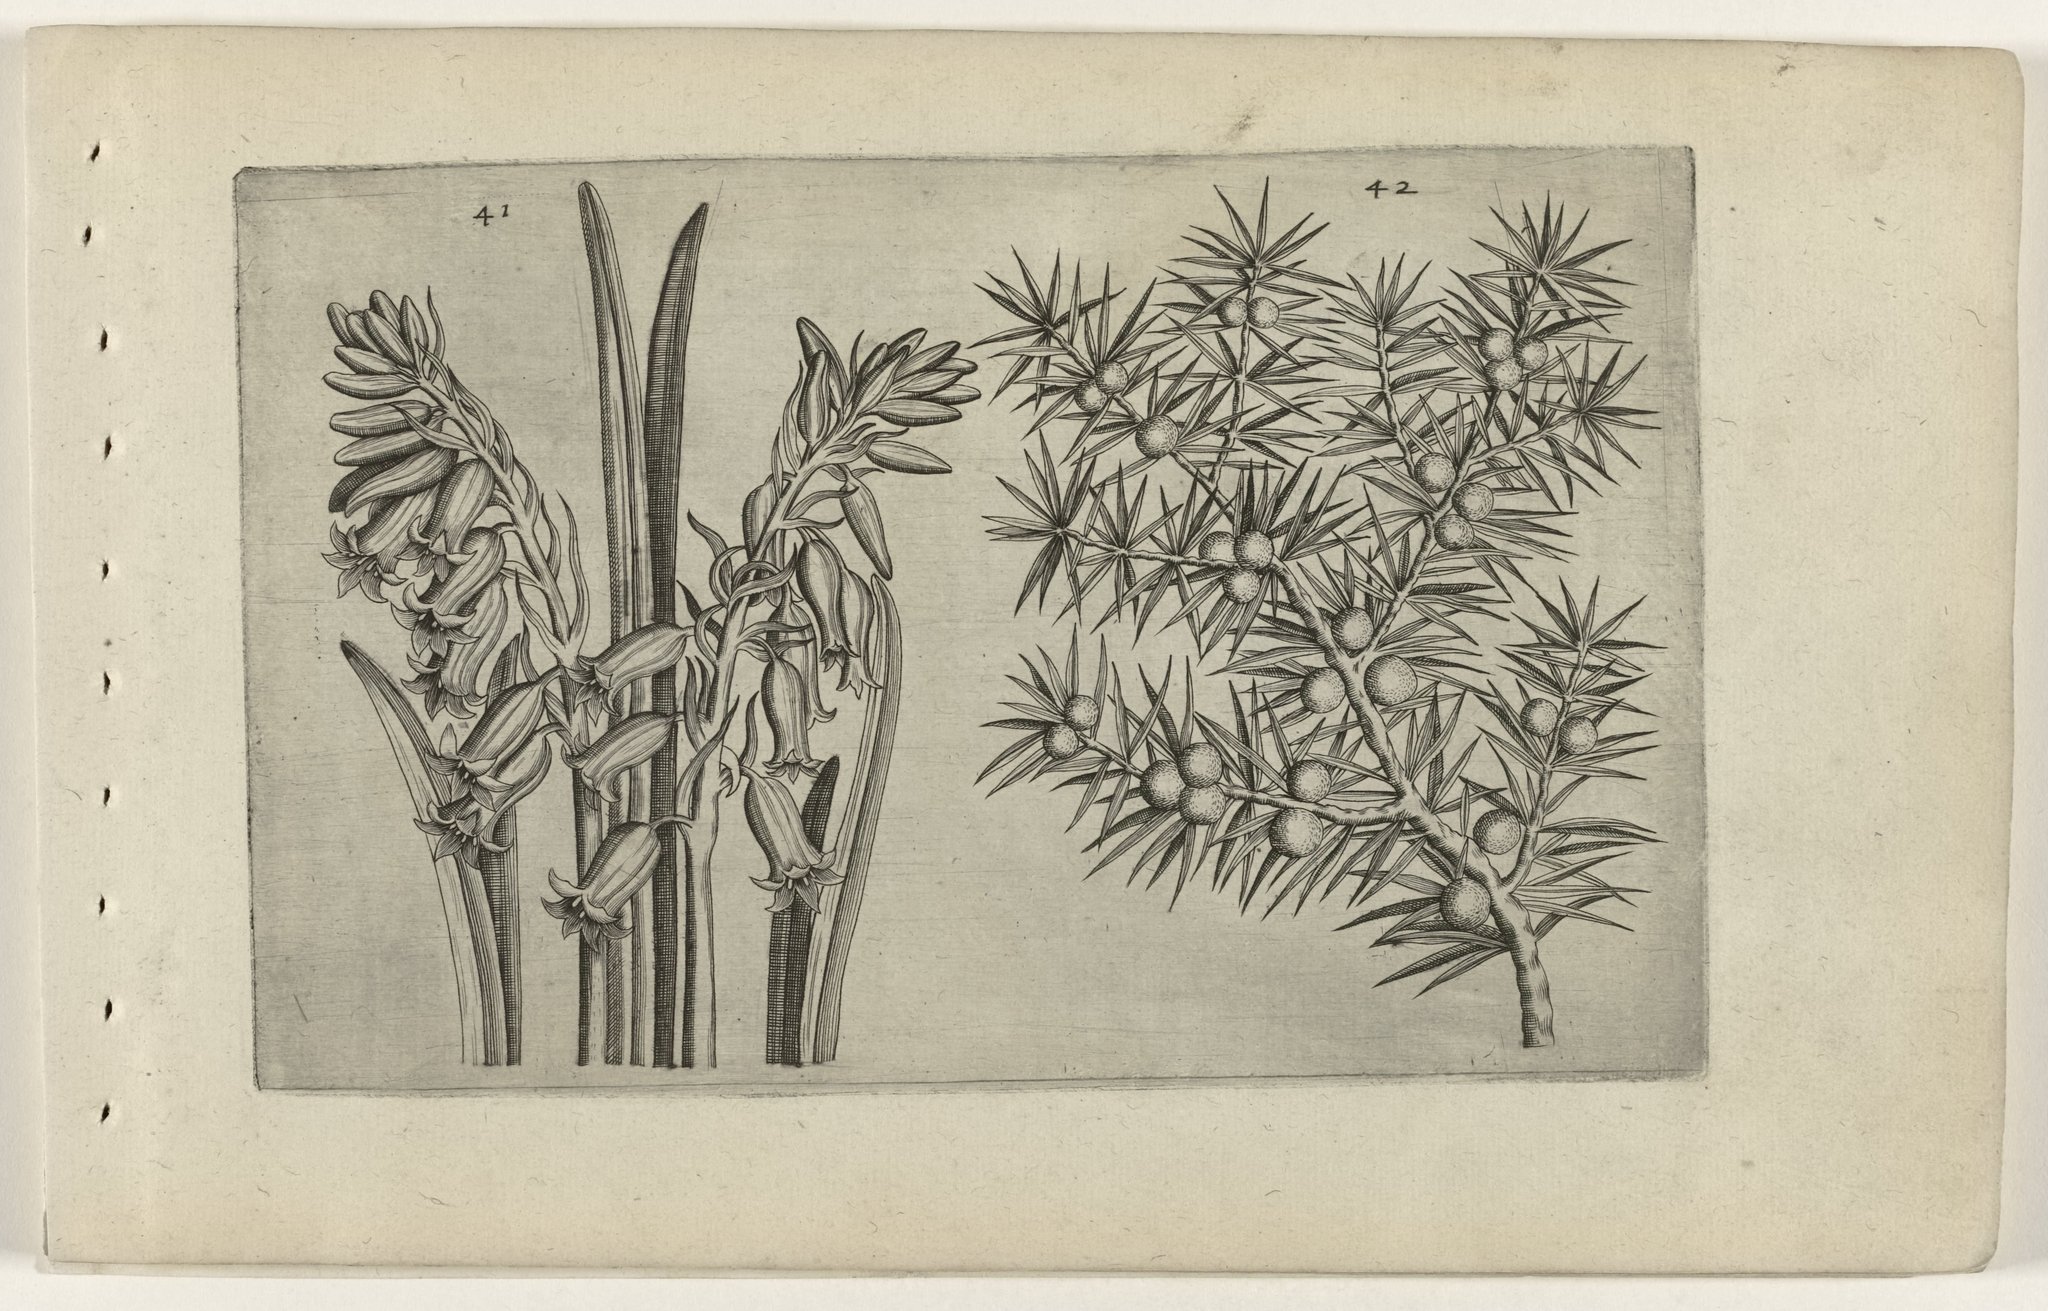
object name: album leaf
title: Hyacint en jeneverbes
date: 1600-1604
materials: paper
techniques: engraving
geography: cologne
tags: shrubs: juniper, botany, flowers: hyacinth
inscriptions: collector's mark: Lugt 2228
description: De prenten RP-P-2012-24-1 t/m 61 waren oorspronkelijk als serie samengebonden. De naaigaten op de bladen zijn nog zichtbaar. Het betreft de reeks getiteld: Cognoscite lilia, bestaande uit een titelprent en 60 gravures met 119 genummerde weergaven van planten, bloemen en vruchten, versierd met rinceaux en kleine voorstellingen van dieren. Het gaat om proefdrukken van deze reeks gravures, voor de opschriften en, deels, voor de nummering. Op enkele prenten zijn de nummers met de hand aangebracht. Op de titelprent ontbreekt nog het adres van Crispijn de Passe en Hans Woutneel. De titel is hoogstwaarschijnlijk gegraveerd door Matthias Quad. Deze werkte voor De Passe in Keulen tot 1604. De reeks moet in dit jaar of daarvoor tot stand zijn gebracht. In ieder geval voor 1608, aangezien de uitgever Hans Woutneel in of voor dat jaar overleed. In ieder geval voor 1608, aangezien de uitgever Hans Woutneel in of voor dat jaar overleed. De gravures worden door Ilja Veldman en Anthony Griffiths beschouwd als eigenhandig werk van Crispijn de Passe I. Een van de prenten uit de reeks ontbreekt (nr 21-22) en is vervangen door een ingekleurde afdruk uit een latere uitgave (RP-P-2012-24-61), die onder de titel Altera Pars is opgenomen in de Hortus Floridus, uitgegeven door Crispijn de Passe I en die verder bestaat uit platen van Crispijn de Passe II. De prenten afkomstig uit deze uitgave zijn op de verso voorzien van tekst in boekdruk. De vervangende prent maakte geen deel uit van de gebonden serie aangezien dit blad als enige geen naaigaten heeft. Een deel van de planten, bloemen en vruchten in de Cognoscite lilia gaat terug of is gebaseerd op een reeks aquarellen van Jacques LeMoyne uit circa 1580 en uit 1585, nu in het Victoria and Albert Museum en de British Museum (zie P. Hulton, Jacques LeMoyne, Londen 1977, dl 1, p. 156-162 en p. 165-173).